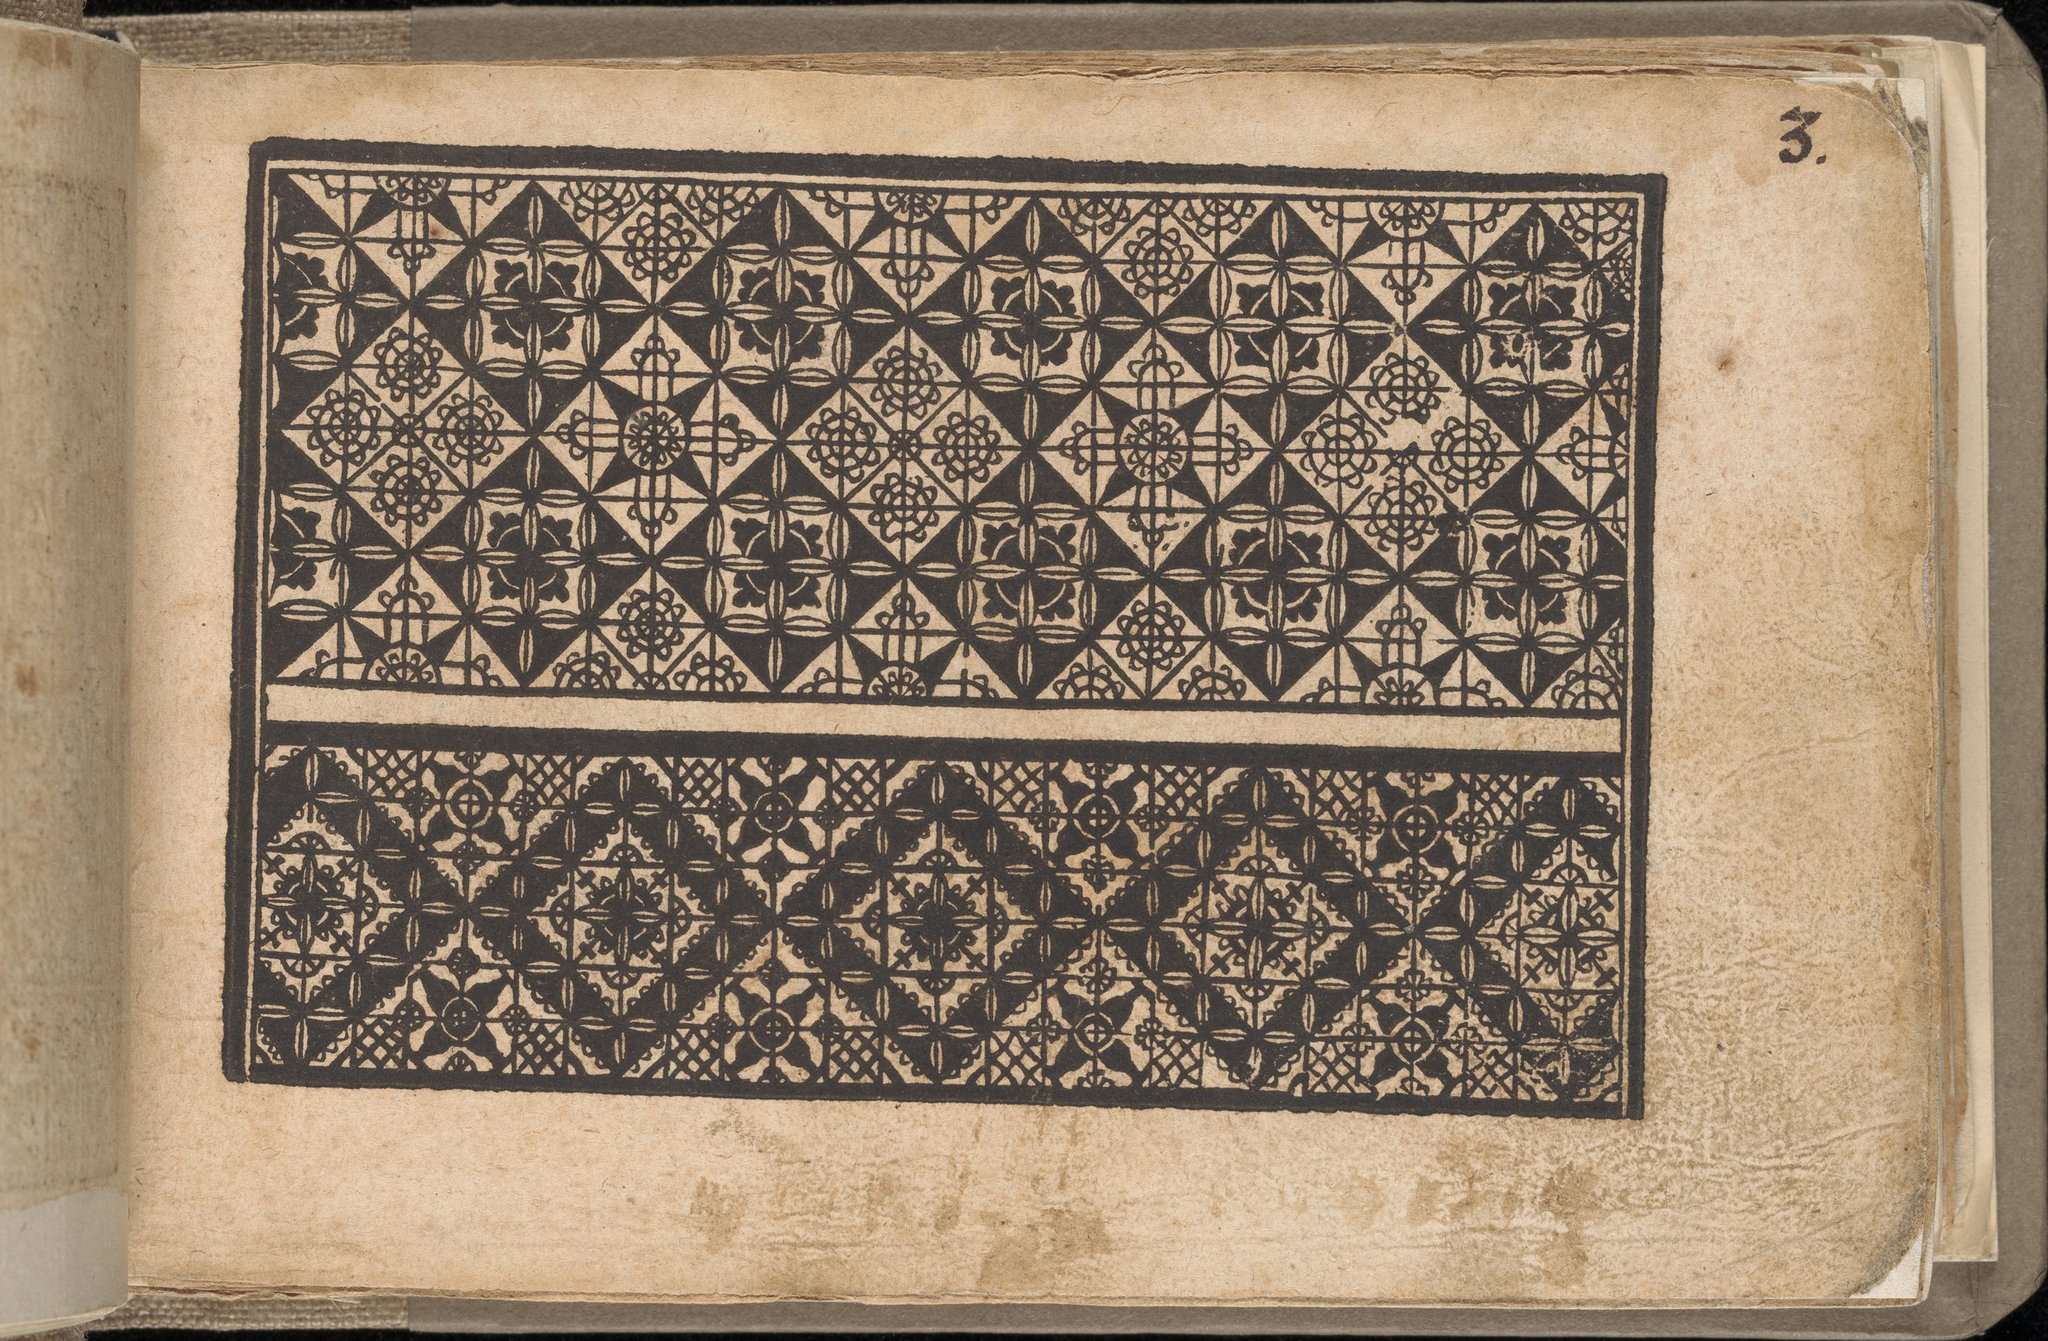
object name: book print ornament architecture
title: Schön newes Modelbuch (Page 3r)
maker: sigismundus latomus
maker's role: publisher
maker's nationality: german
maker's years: 1599-1632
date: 1608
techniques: woodcut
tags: ornament